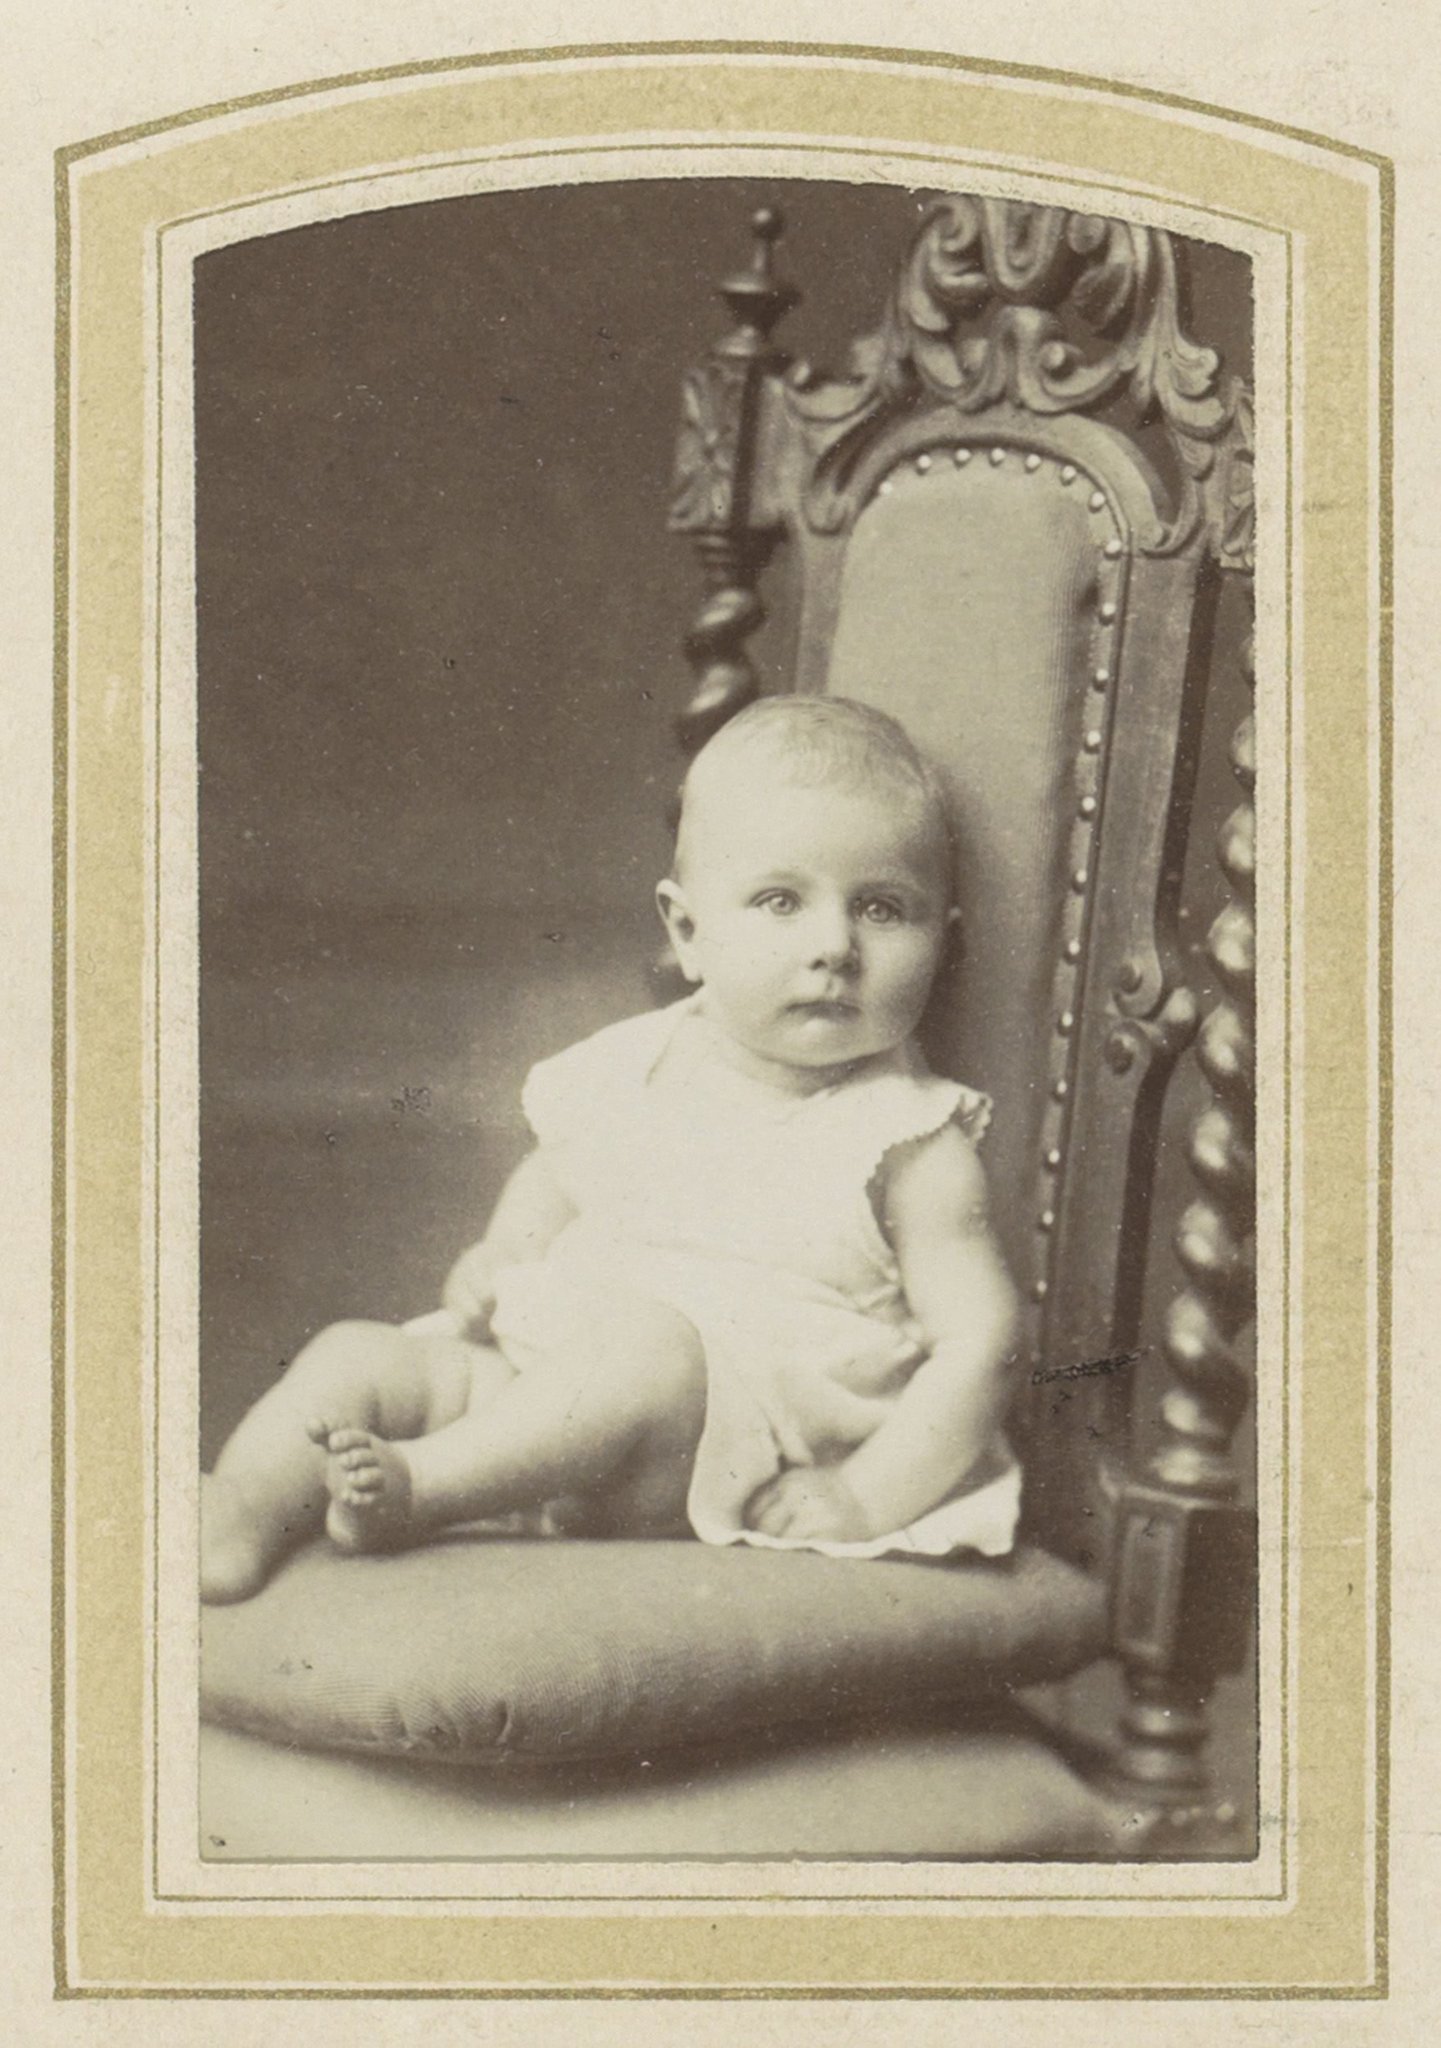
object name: carte de visite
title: Portret van een baby op een stoel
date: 1864-1887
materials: cardboard, paper, photographic support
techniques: albumen print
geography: netherlands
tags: studio requisites ~ photographer, historical persons, clothes covering the entire body, infant, baby ~ the ages of man, netherlands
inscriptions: address: ‘Amsterdam Rokin over de Bank 138 Utrecht Hamburgerstraat F 237’, address: ‘Amsterdam-Utrecht’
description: Onderdeel van Fotoalbum van een Nederlandse familie met 168 cartes-de-visite en kabinetfoto's.